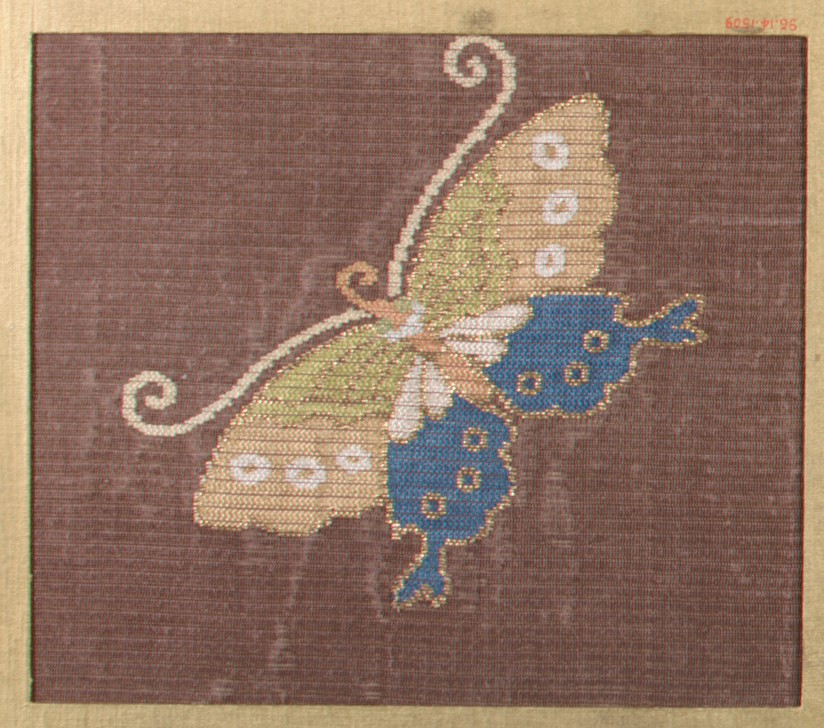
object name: piece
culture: japanese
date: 1701-1900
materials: silk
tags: butterflies